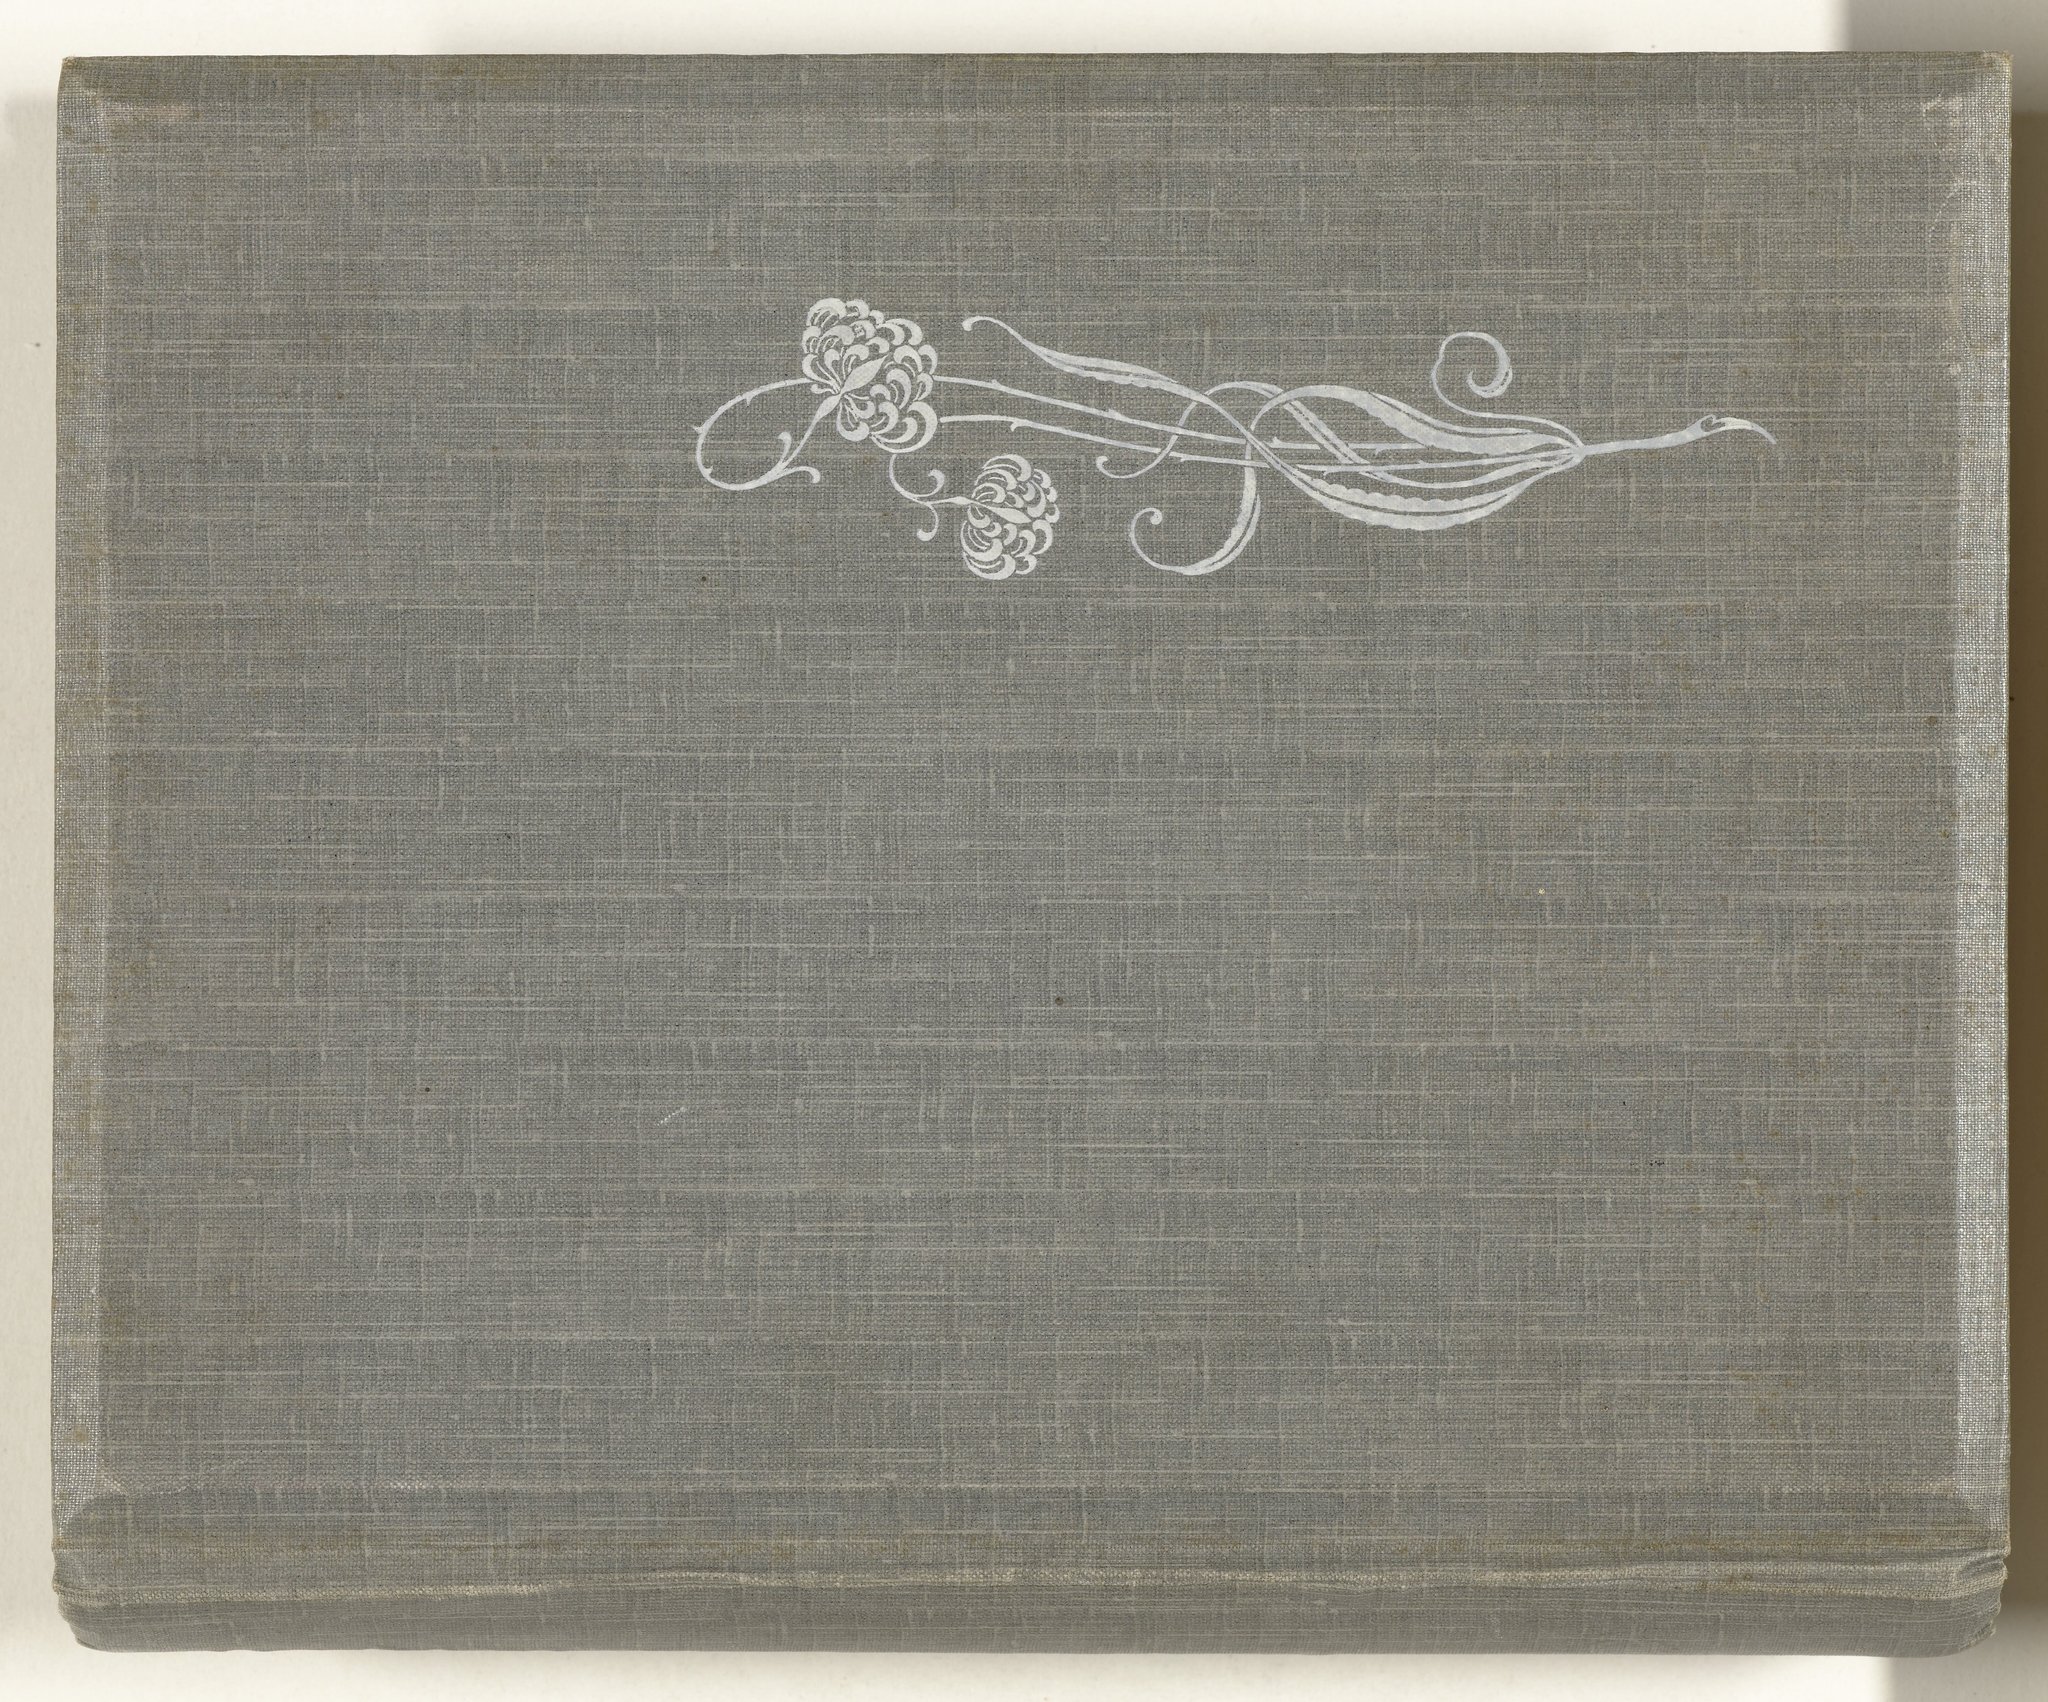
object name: photograph album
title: J.B. Aug. Kessler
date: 1900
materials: paper, photographic support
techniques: gelatin silver print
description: Fotoalbum J.B. Aug. Kessler met 18 foto's.